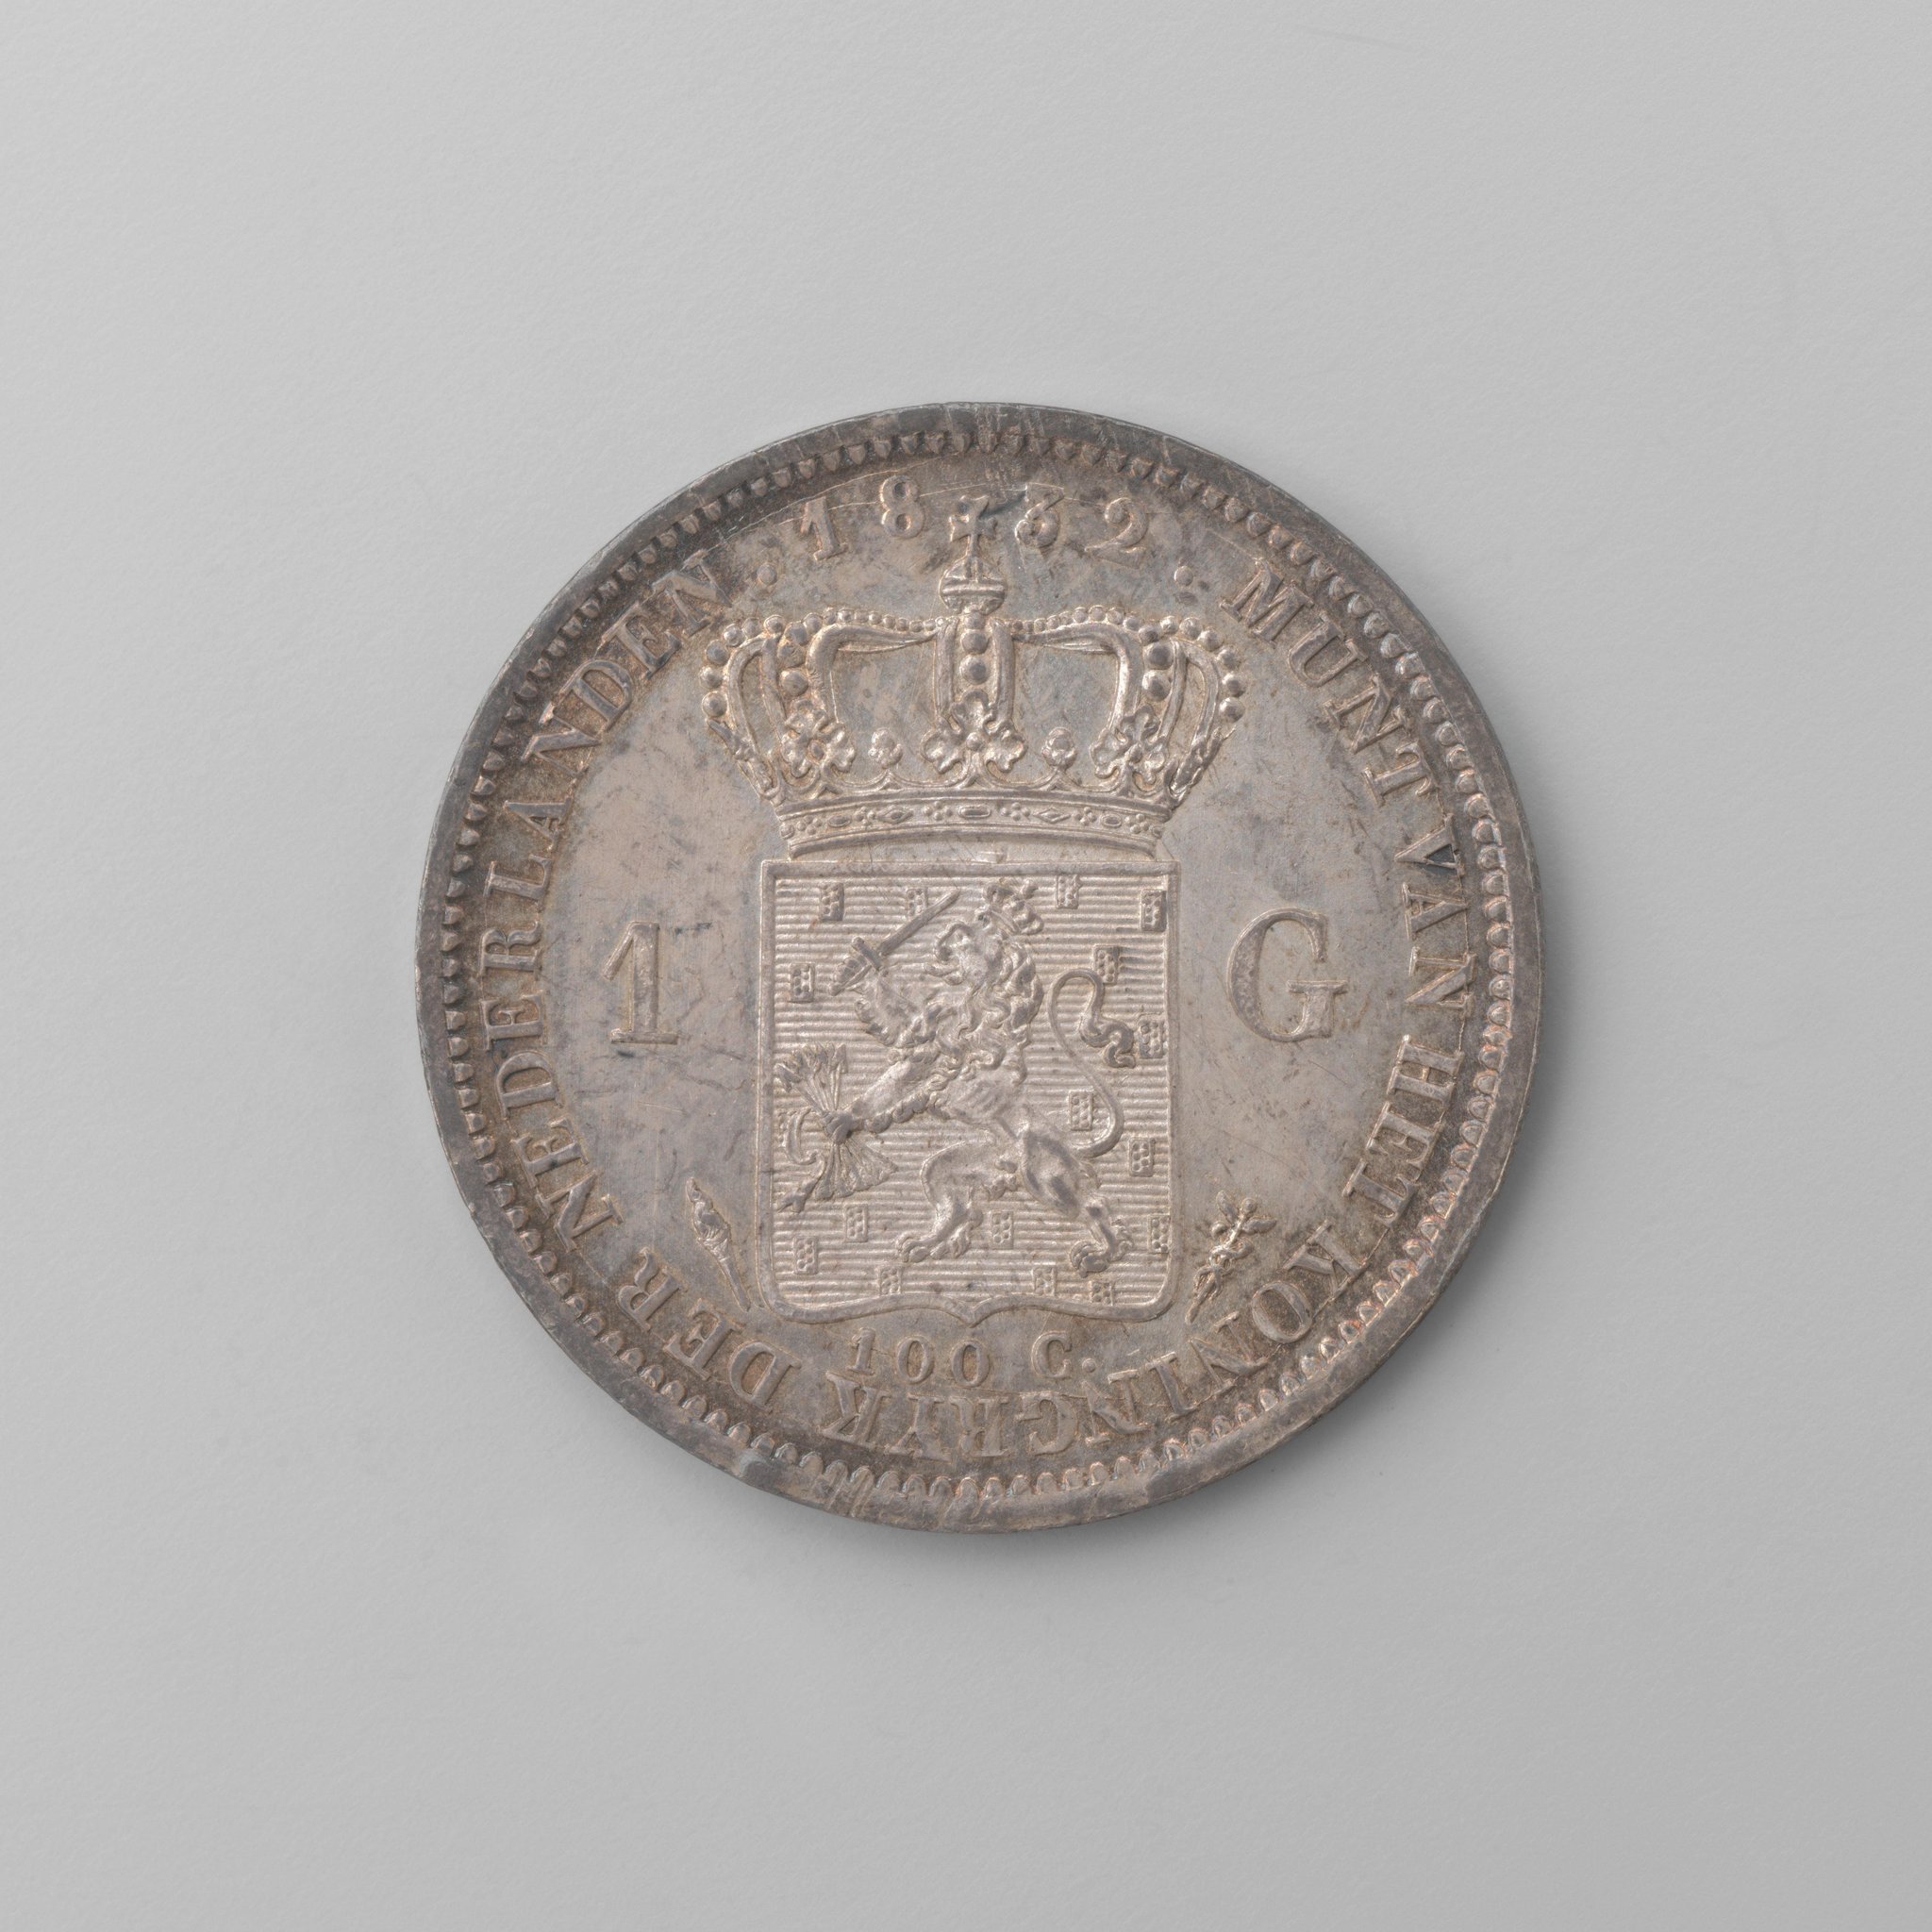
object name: coin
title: Nederlandse gulden, 1832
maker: william i of the netherlands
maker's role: koning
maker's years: 1772-1843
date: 1832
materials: silver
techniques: striking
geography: utrecht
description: Zilveren munt. Voorzijde: borstbeeld naar rechts. Keerzijde: tussen waarde-aanduiding 1 G gekroond rijkswapenschild. Jaartal boven kroon. Randschrift.